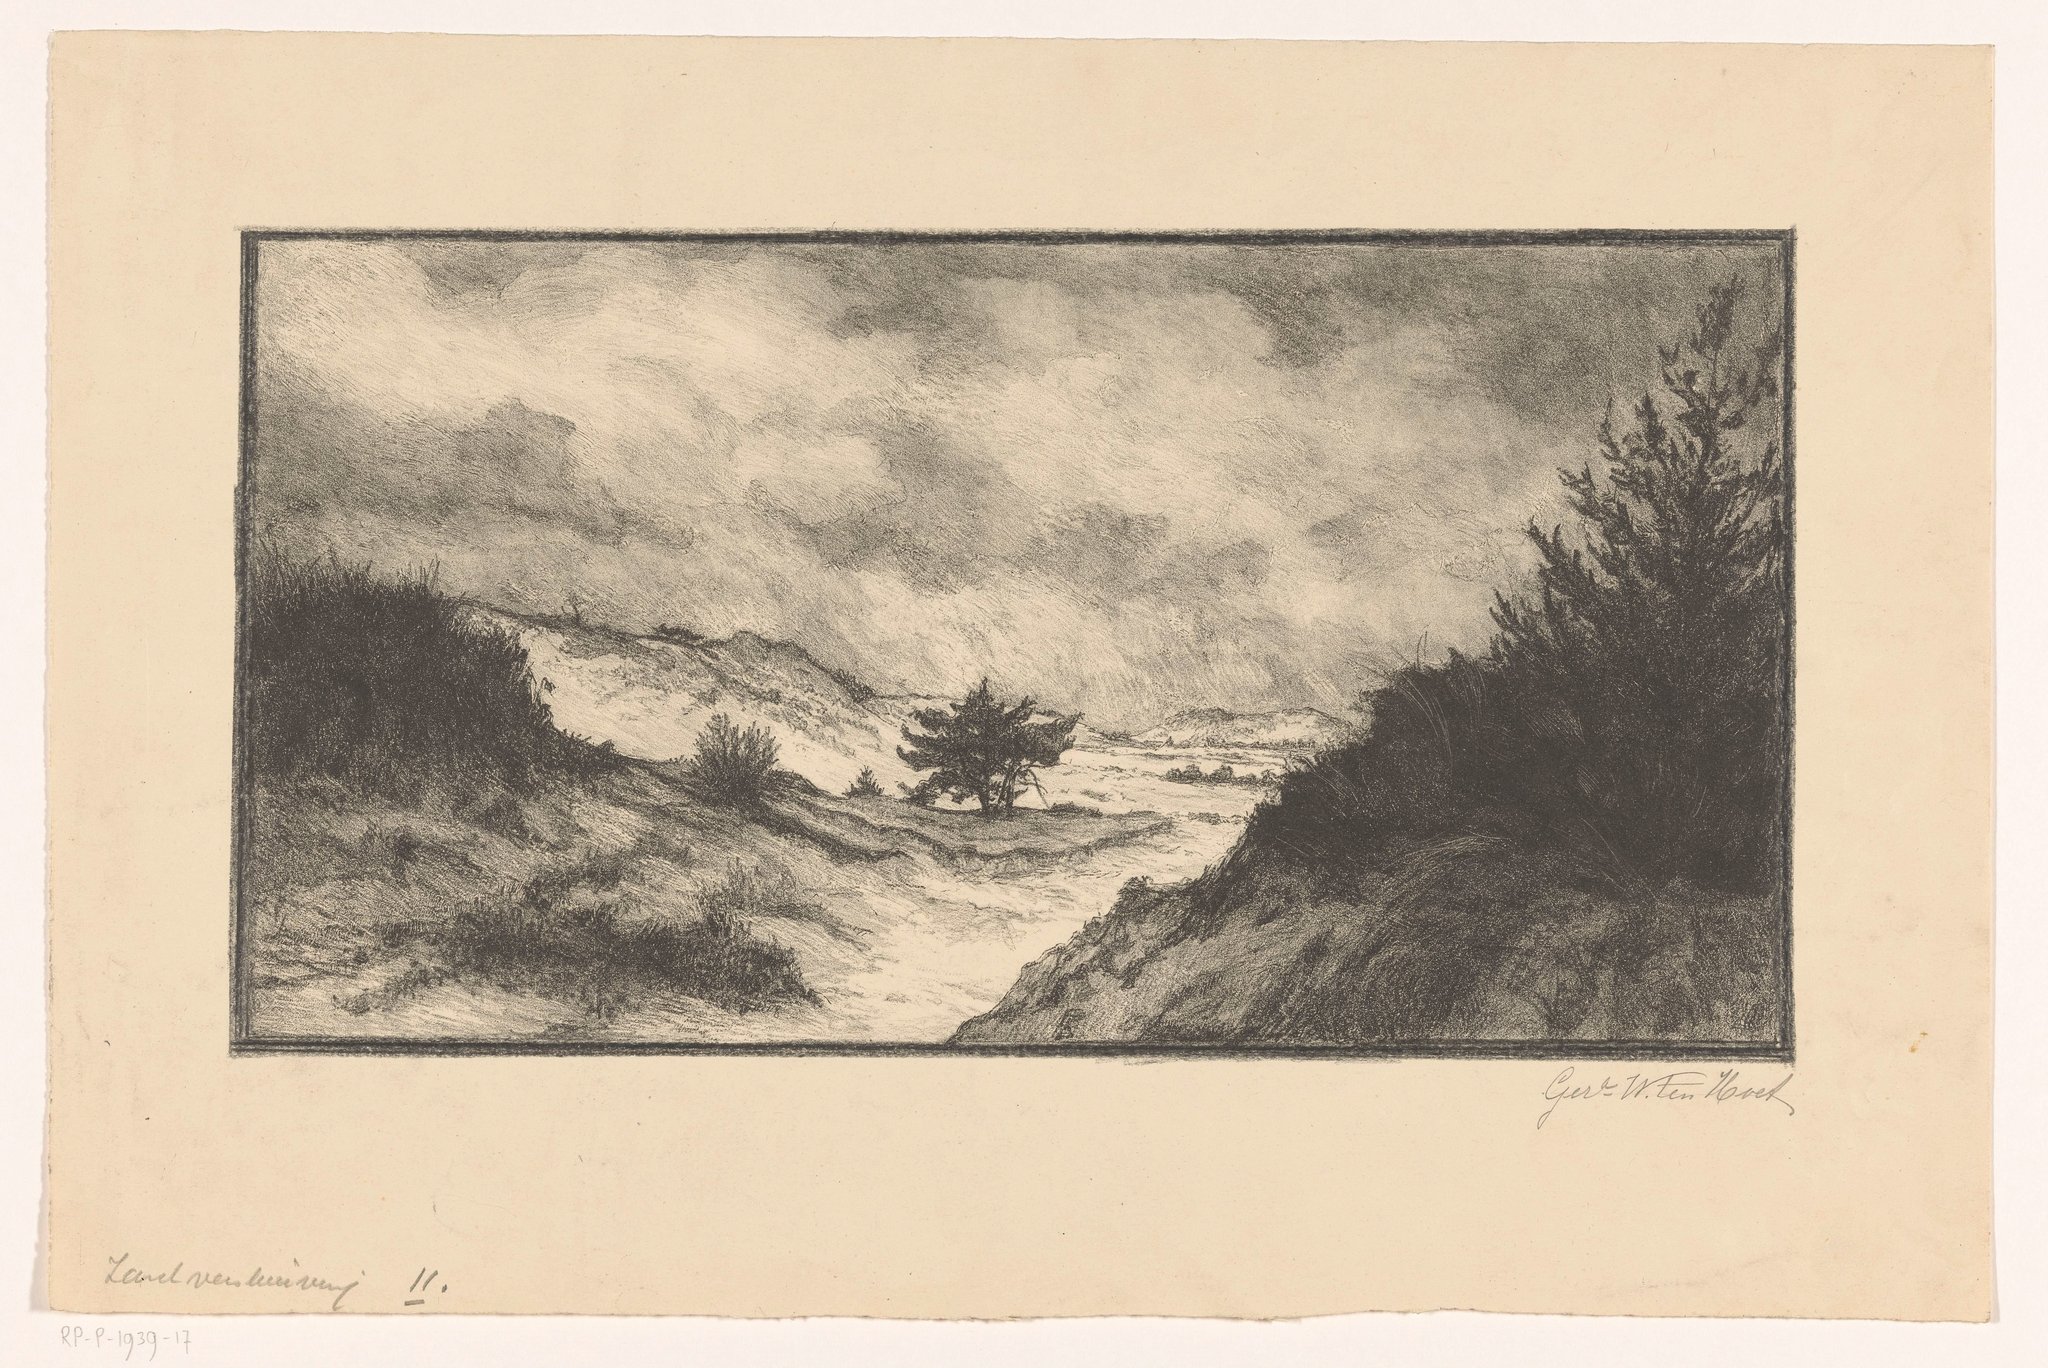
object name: print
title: Zandverstuiving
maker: gerarda wilhelmina ten hoet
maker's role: print maker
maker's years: 1857-1939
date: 1867-1939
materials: paper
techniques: lithograph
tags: dunes (sea not visible); in the dunes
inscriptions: collector's mark: Lugt 2228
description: Duinlandschap met in het midden een struik.